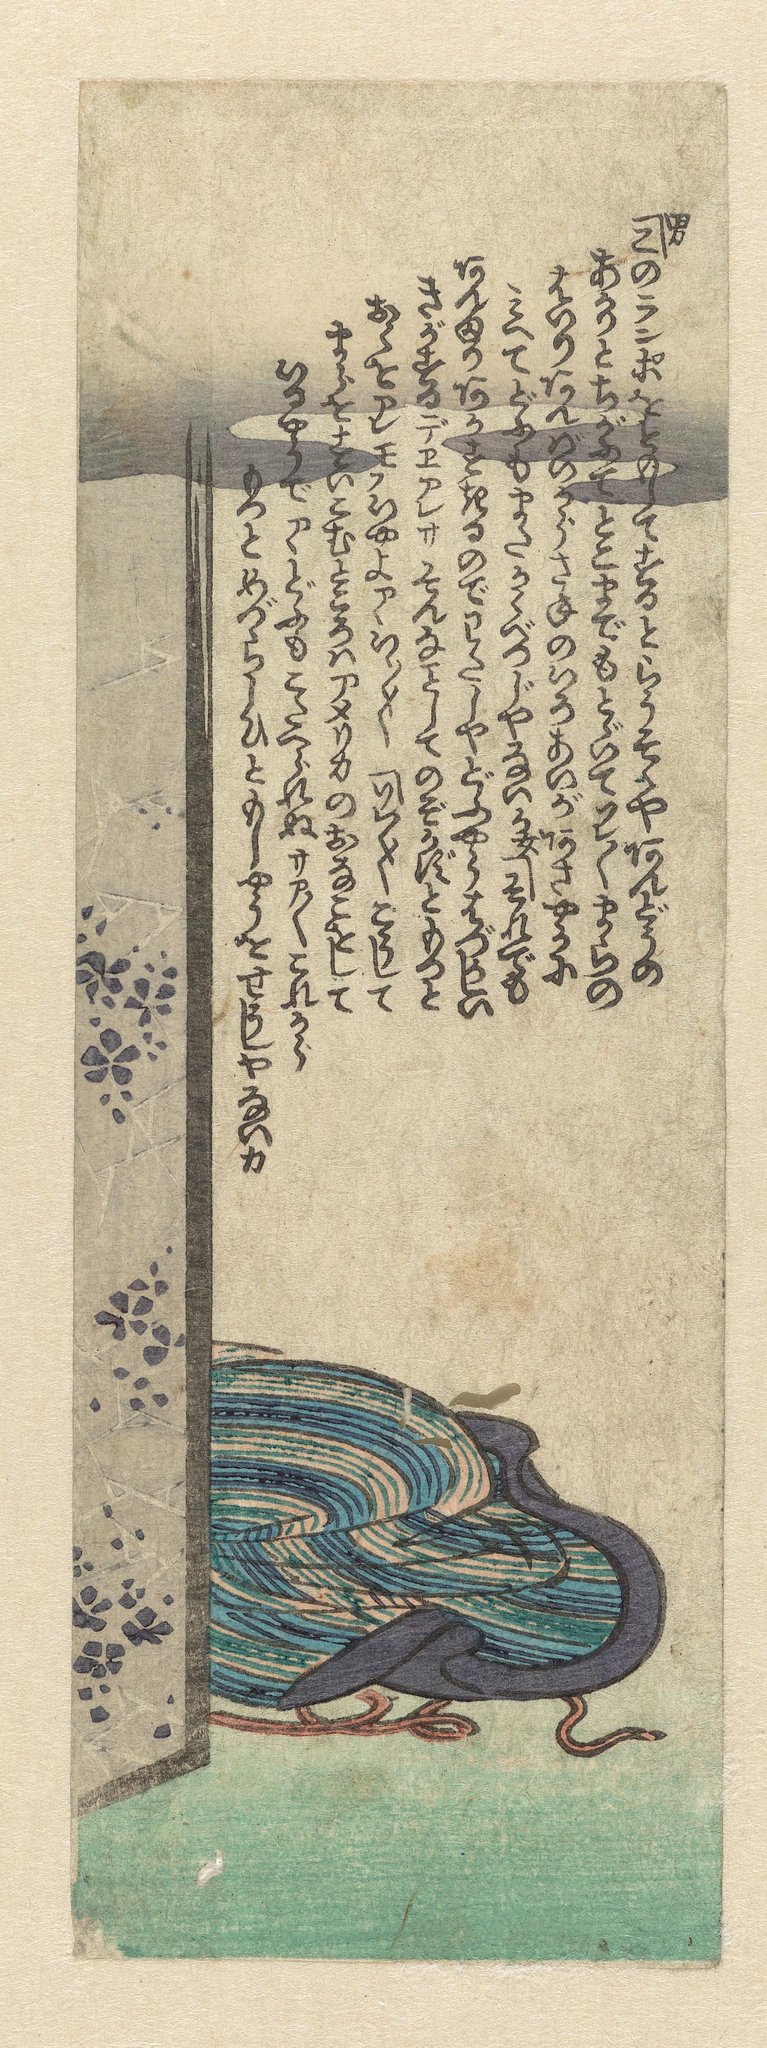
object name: print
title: Achtdelige serie met shunga-prenten (iro yôkan; zenbu hitosao)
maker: Anonymous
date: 1850-1860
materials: paper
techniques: woodcut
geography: japan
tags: clothes for special purposes